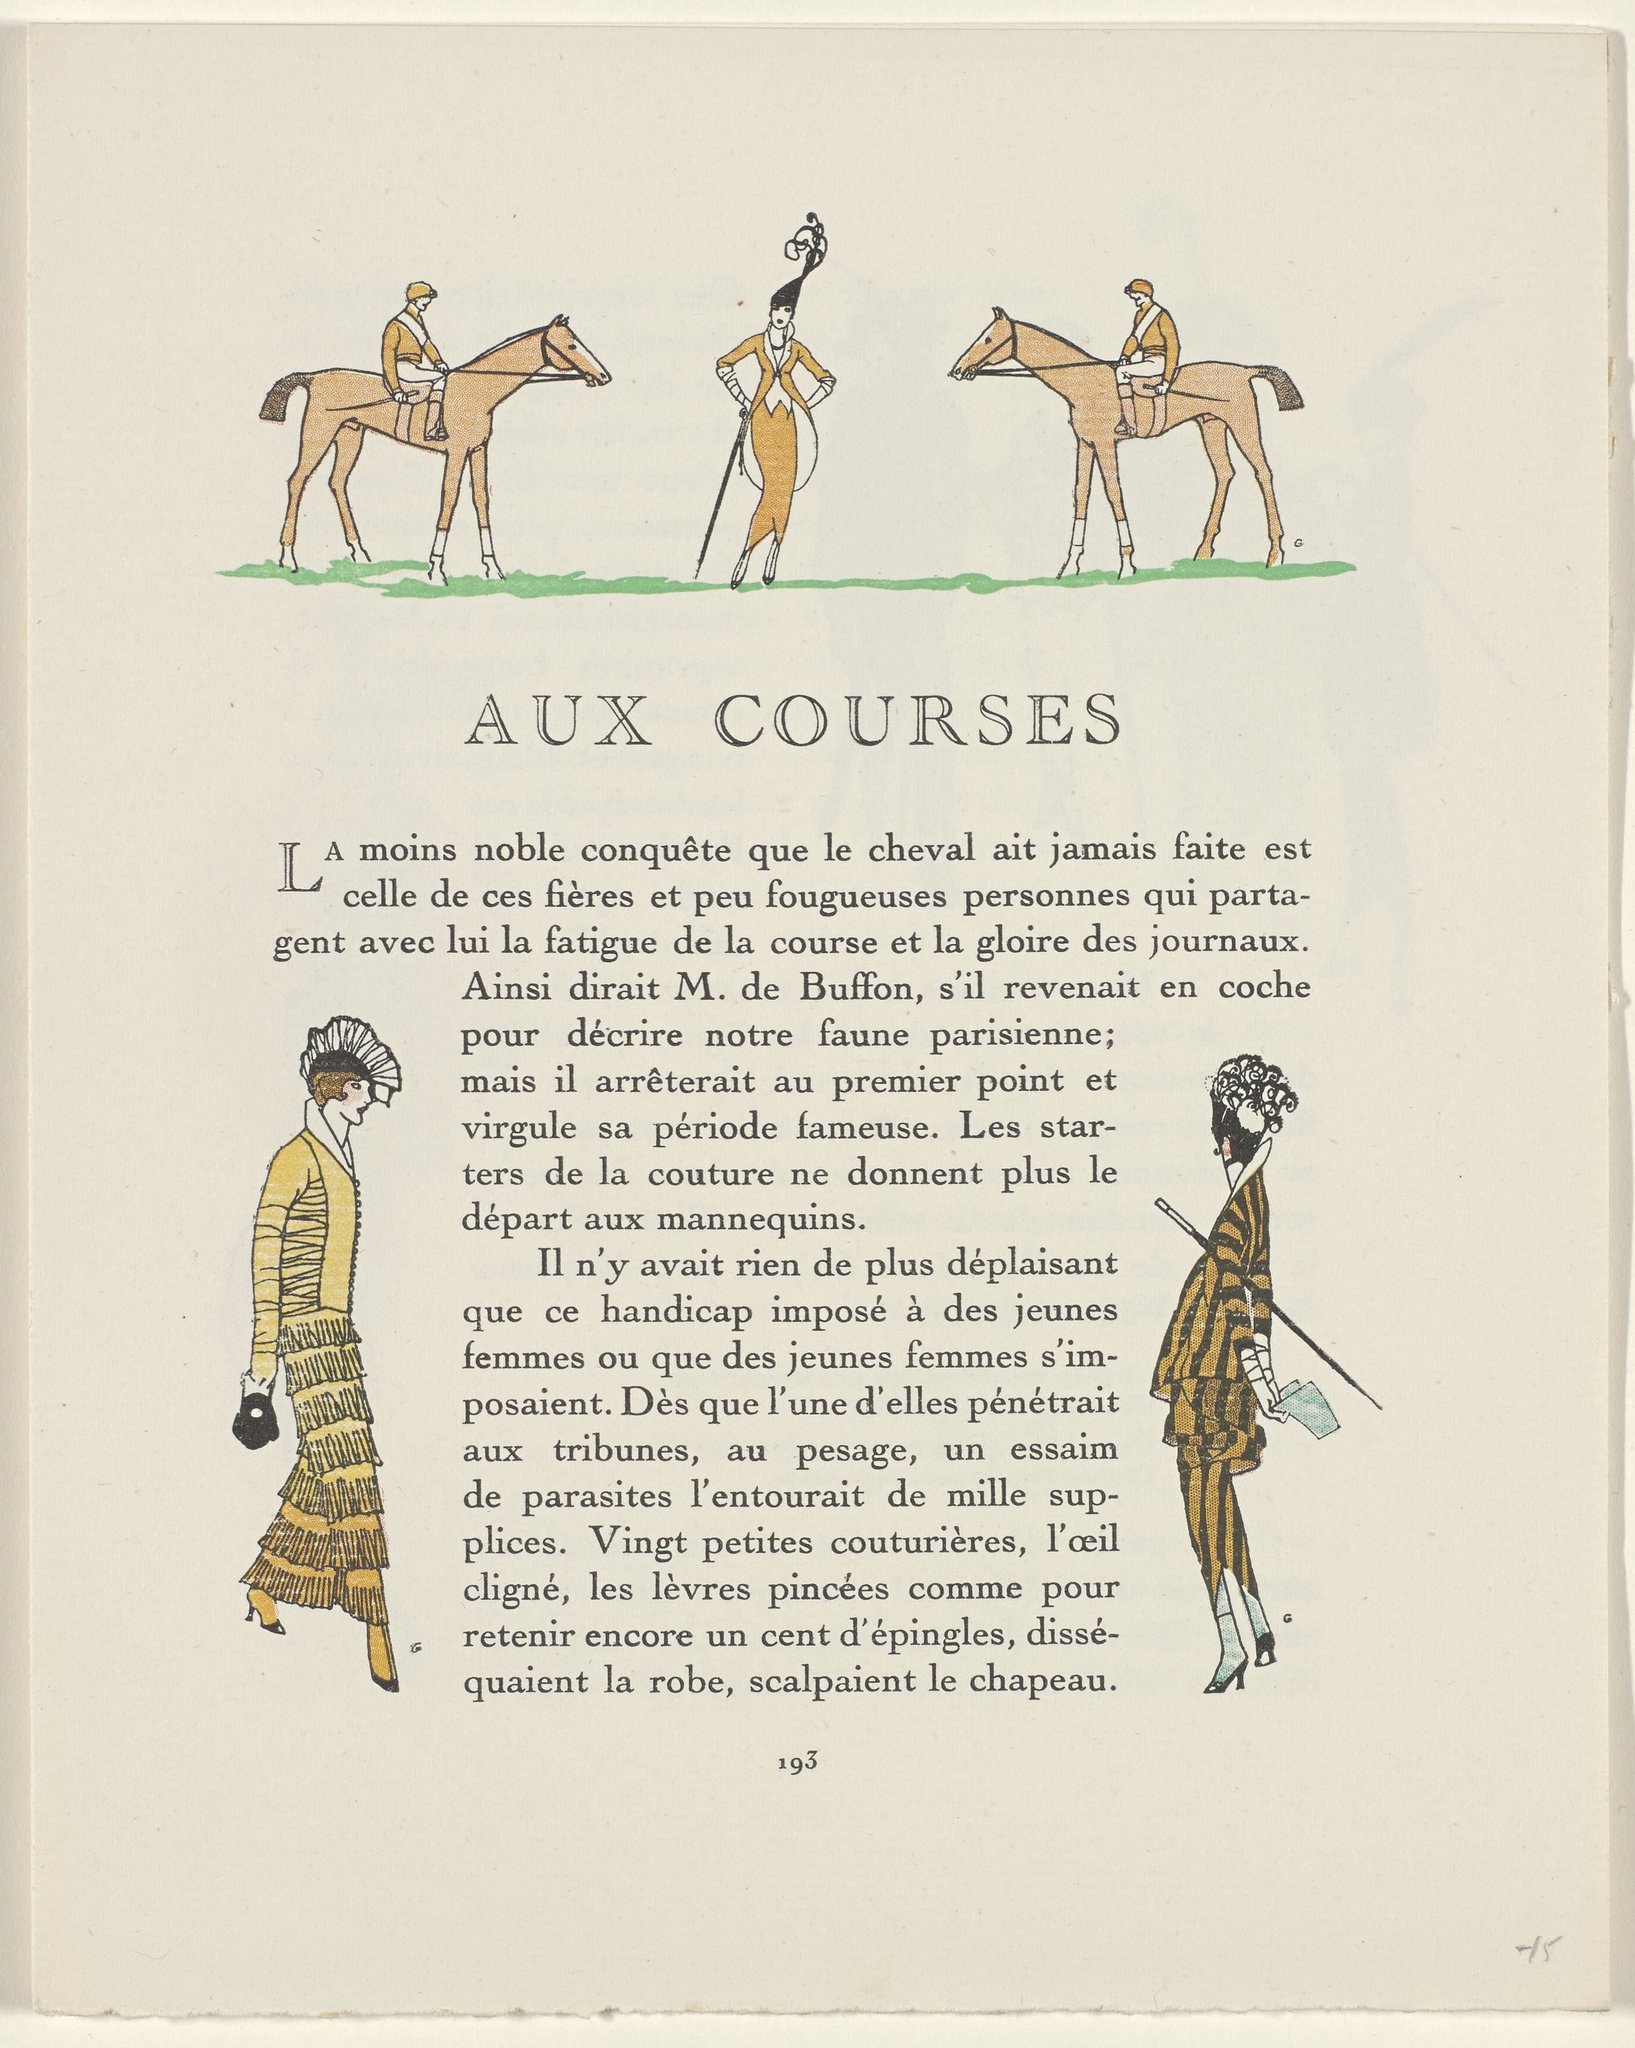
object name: fashion print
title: Gazette du Bon Ton, 1914 - No. 6, p. 193: Aux Courses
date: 1914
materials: paper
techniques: letterpress printing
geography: berlin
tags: fashion plates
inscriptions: date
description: Aux Courses. Tekst van Régis Gignoux, met illustraties: ruiters en twee vrouwen in tailleurs. Pagina 193 in Gazette du Bon Ton, 1914 - No. 6